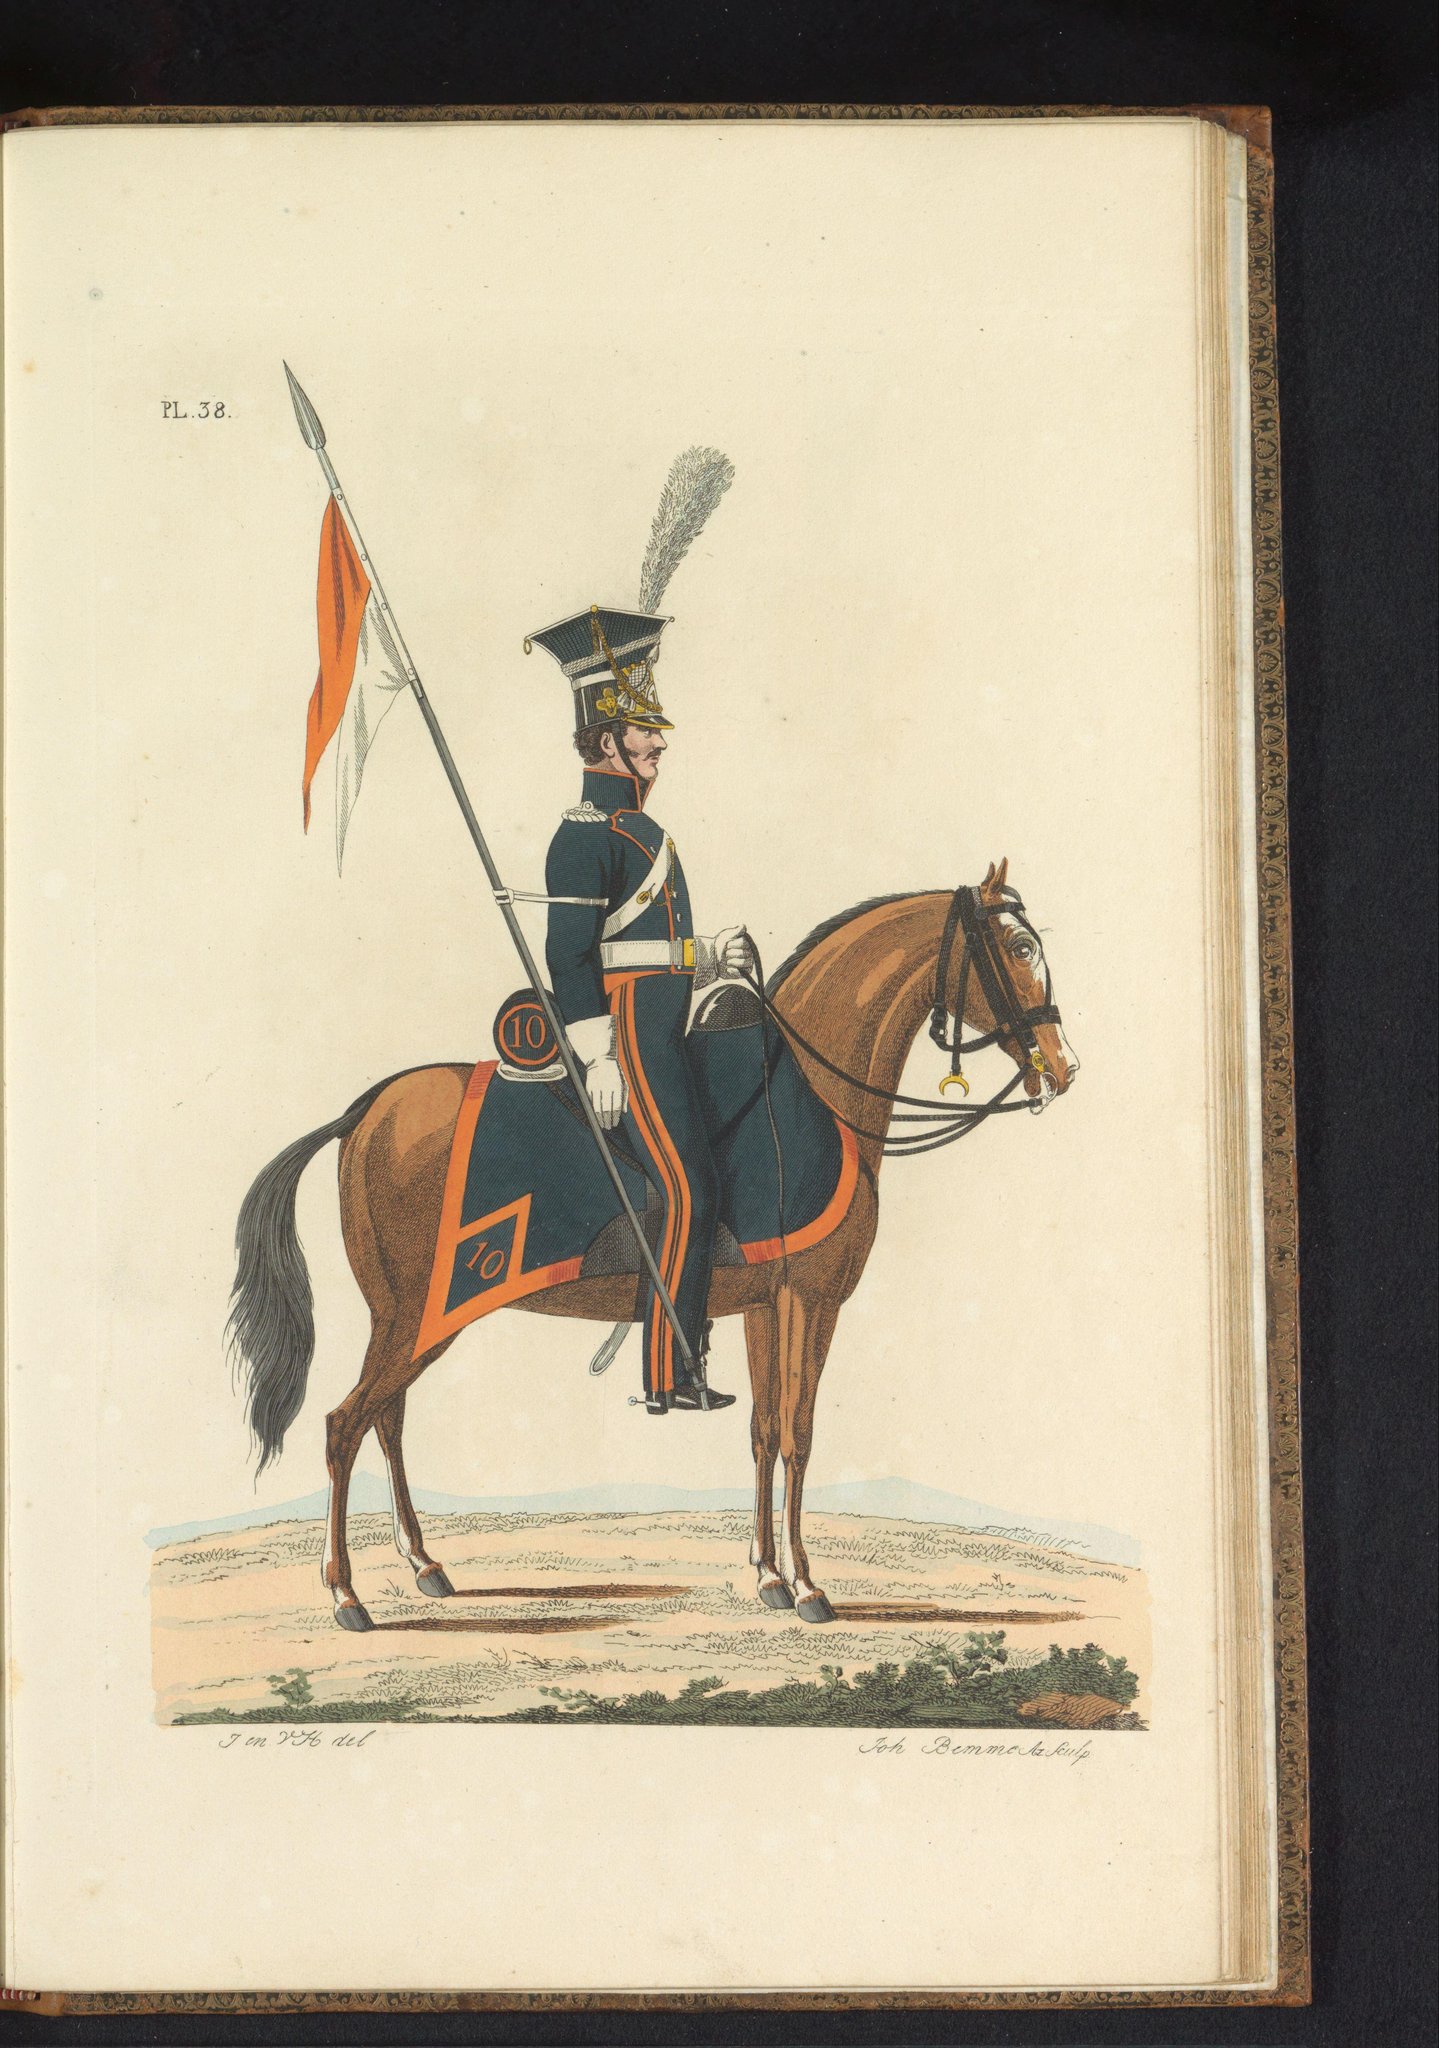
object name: print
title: Lancier, te paard, in groote tenue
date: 1823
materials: paper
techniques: engraving, etching, hand coloring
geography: the hague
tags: (military) uniforms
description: Een Nederlandse lansier van het Regiment Lansiers Nr 10, te paard in grote tenue. Plaat 38. Uniformvoorstelling in 'Beschrijving hoedanig de Koninklijke Nederlandsche troepen' van J.F. Teupken, 1823.